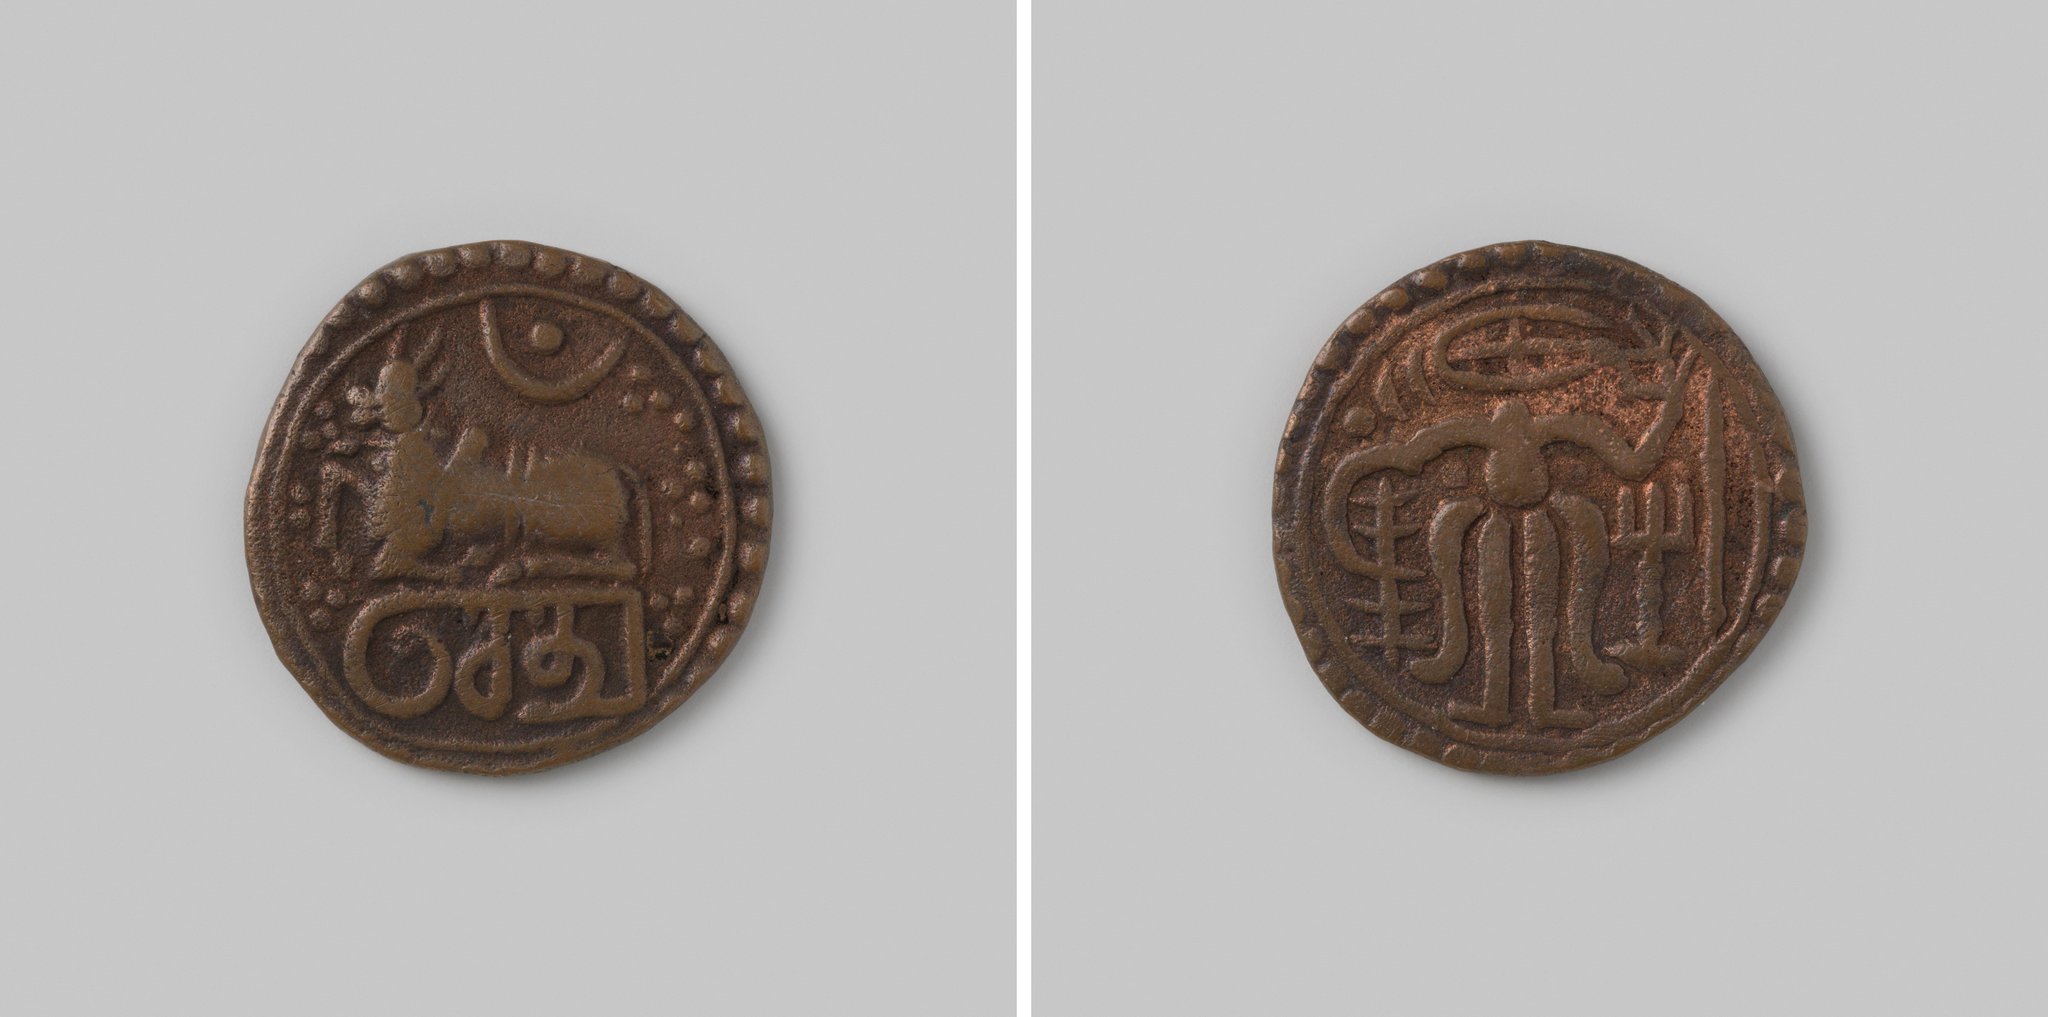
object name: coin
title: Jaffna, Sri Lanka, Ceylon, Arya Chakravartis, 1286-1410 en 1462-1597, kahavanu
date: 1286-1597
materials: copper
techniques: striking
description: Koperen munt. Voorzijde: zittende stier met sralenkrans naar links, waarboven wassende maan, waarin punt. Onder de stier in een regel opschrift in het Tamil: Setu. Keerzijde: staande figuur, waaromheen symbolen.